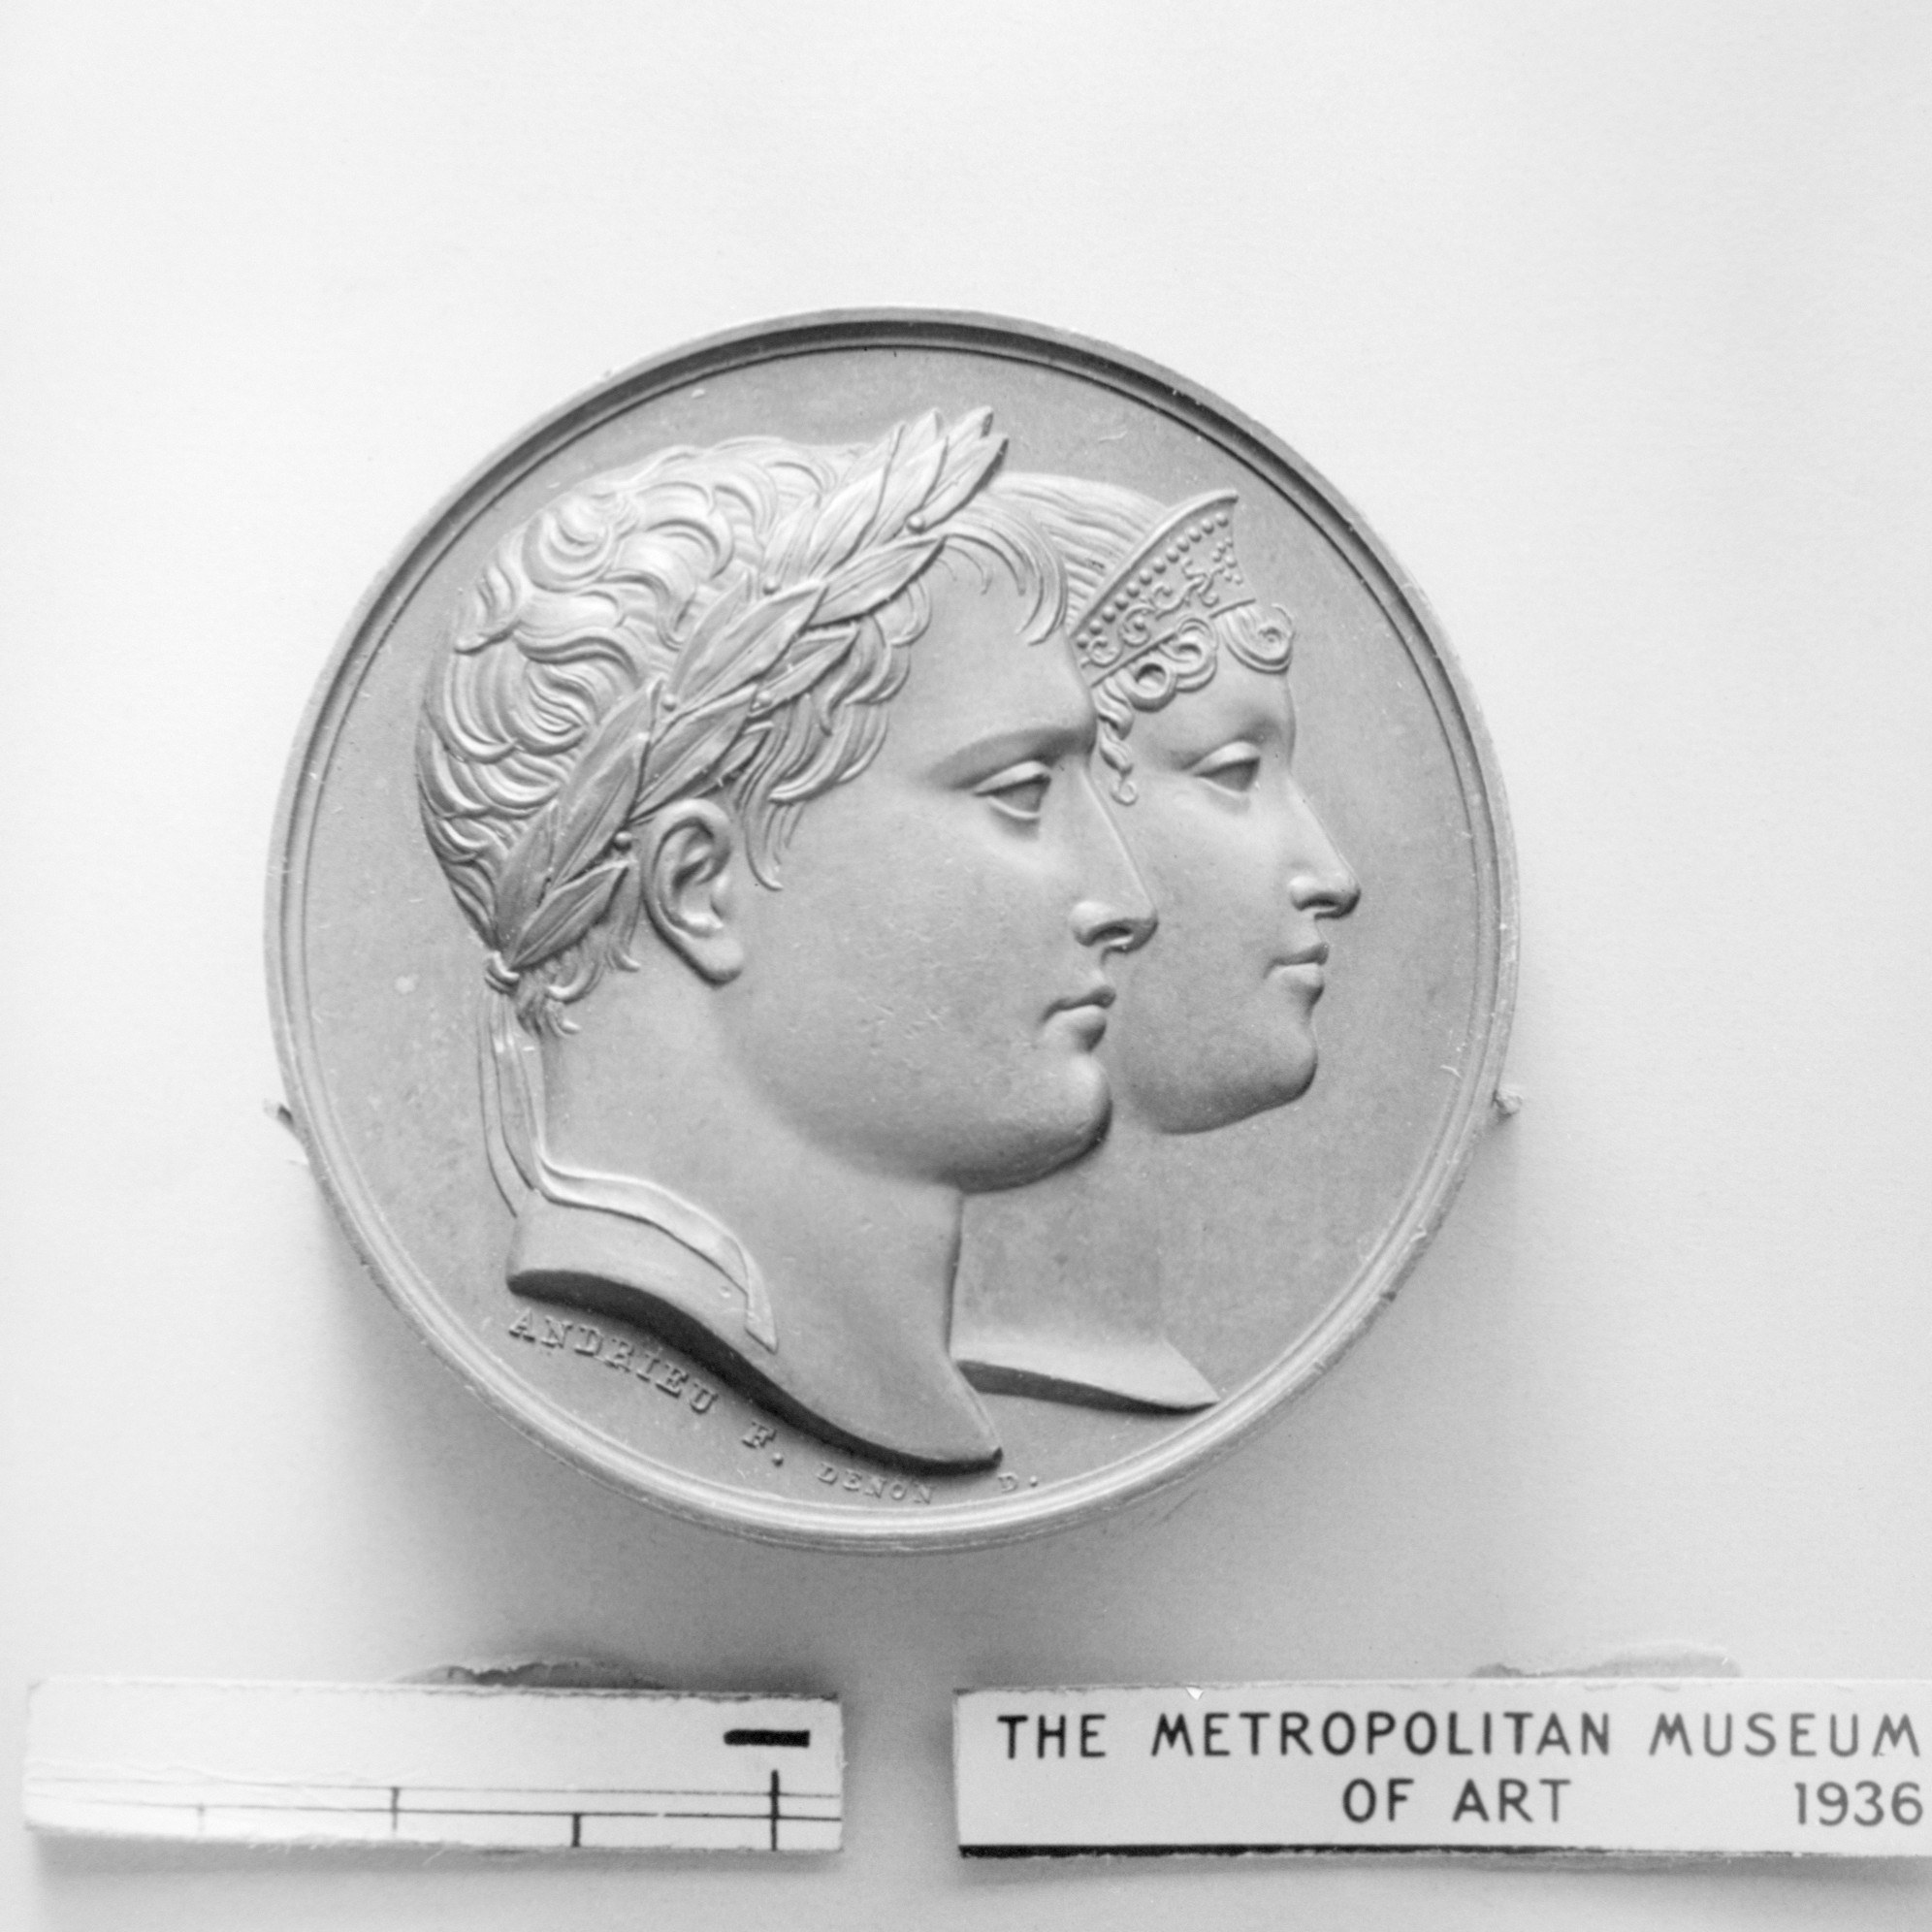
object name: medal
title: Medal commemorating the birth of the King of Rome (1811–1832)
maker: bertrand andrieu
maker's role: artist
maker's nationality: french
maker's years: 1761-1822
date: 1811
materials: bronze, patina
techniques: struck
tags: kings,queens,profiles